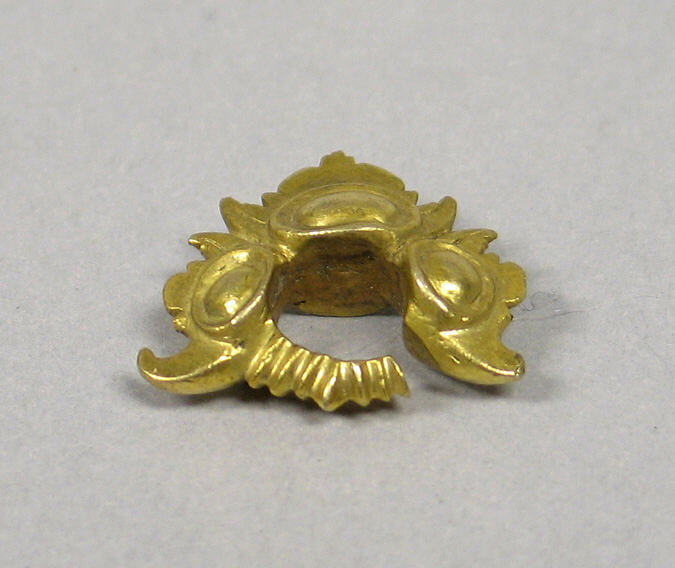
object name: ornament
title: Ornament in the Form of a Bud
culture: indonesian, central java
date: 701-1200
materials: gold